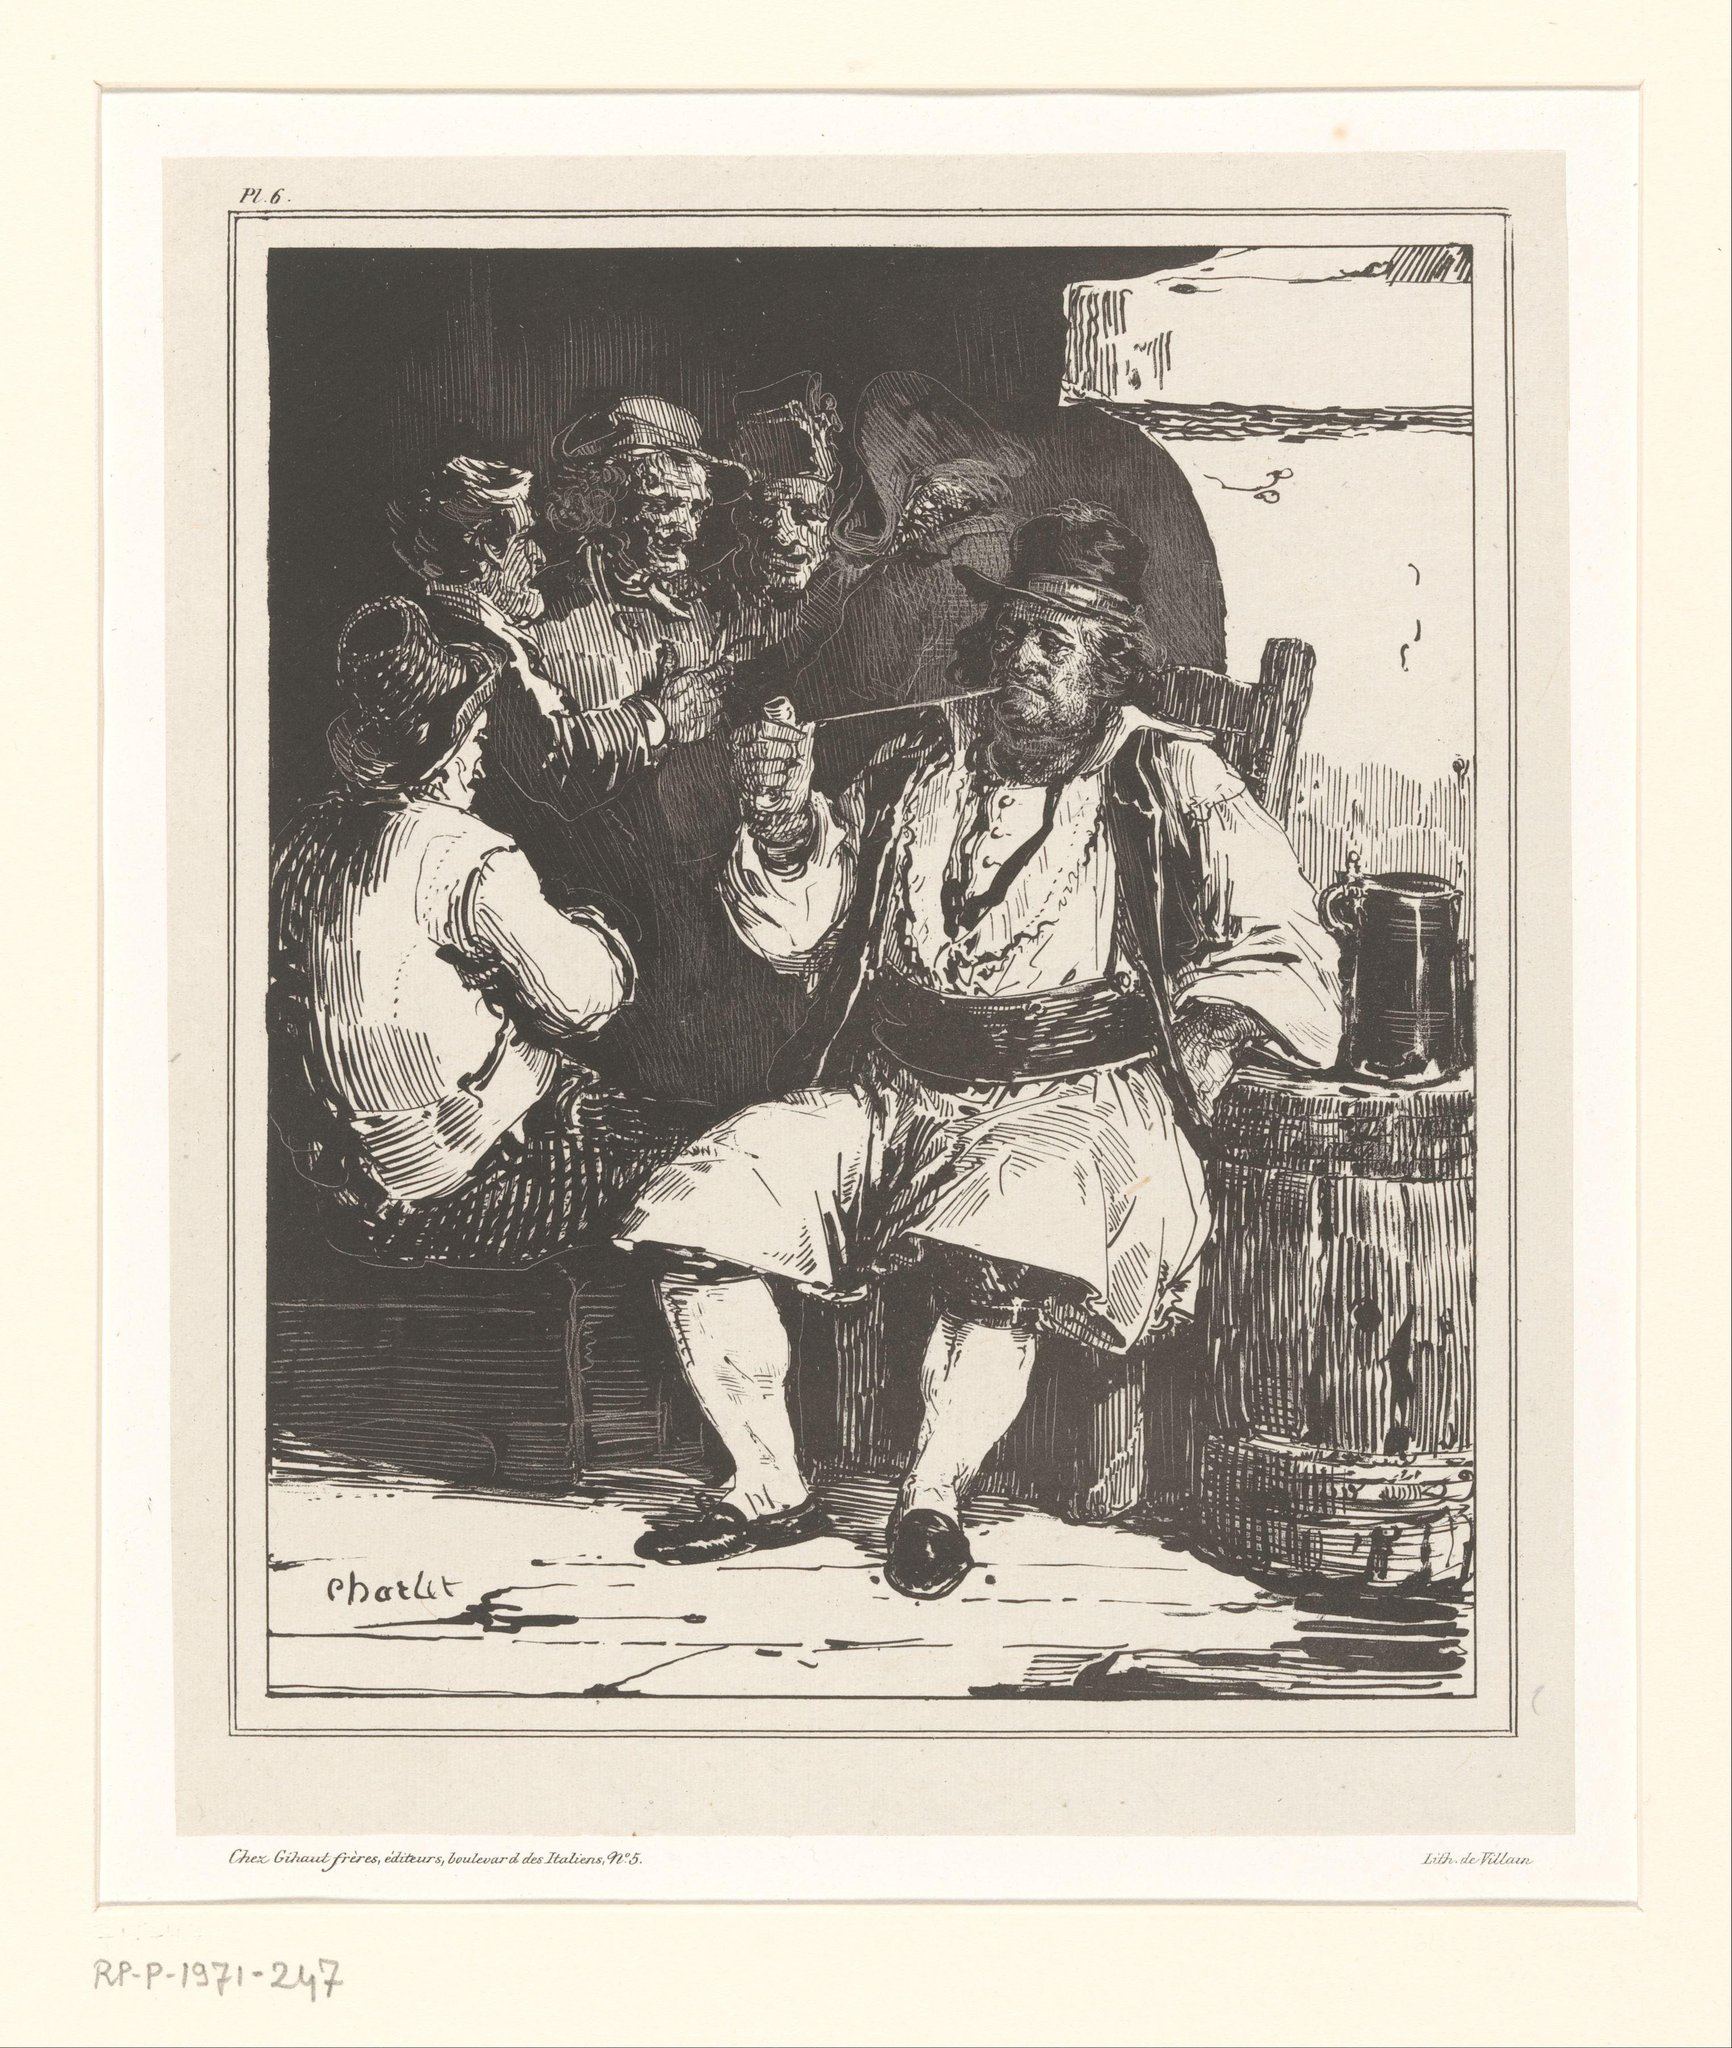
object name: print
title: Oude zeeman rookt een pijp in een kroeg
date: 1828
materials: paper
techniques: lithograph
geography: paris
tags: inn, coffee-house, public house, etc., pipe ~ tobacco, seaman: sailor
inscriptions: collector's mark: Lugt 2760, collector's mark: Lugt 2228a